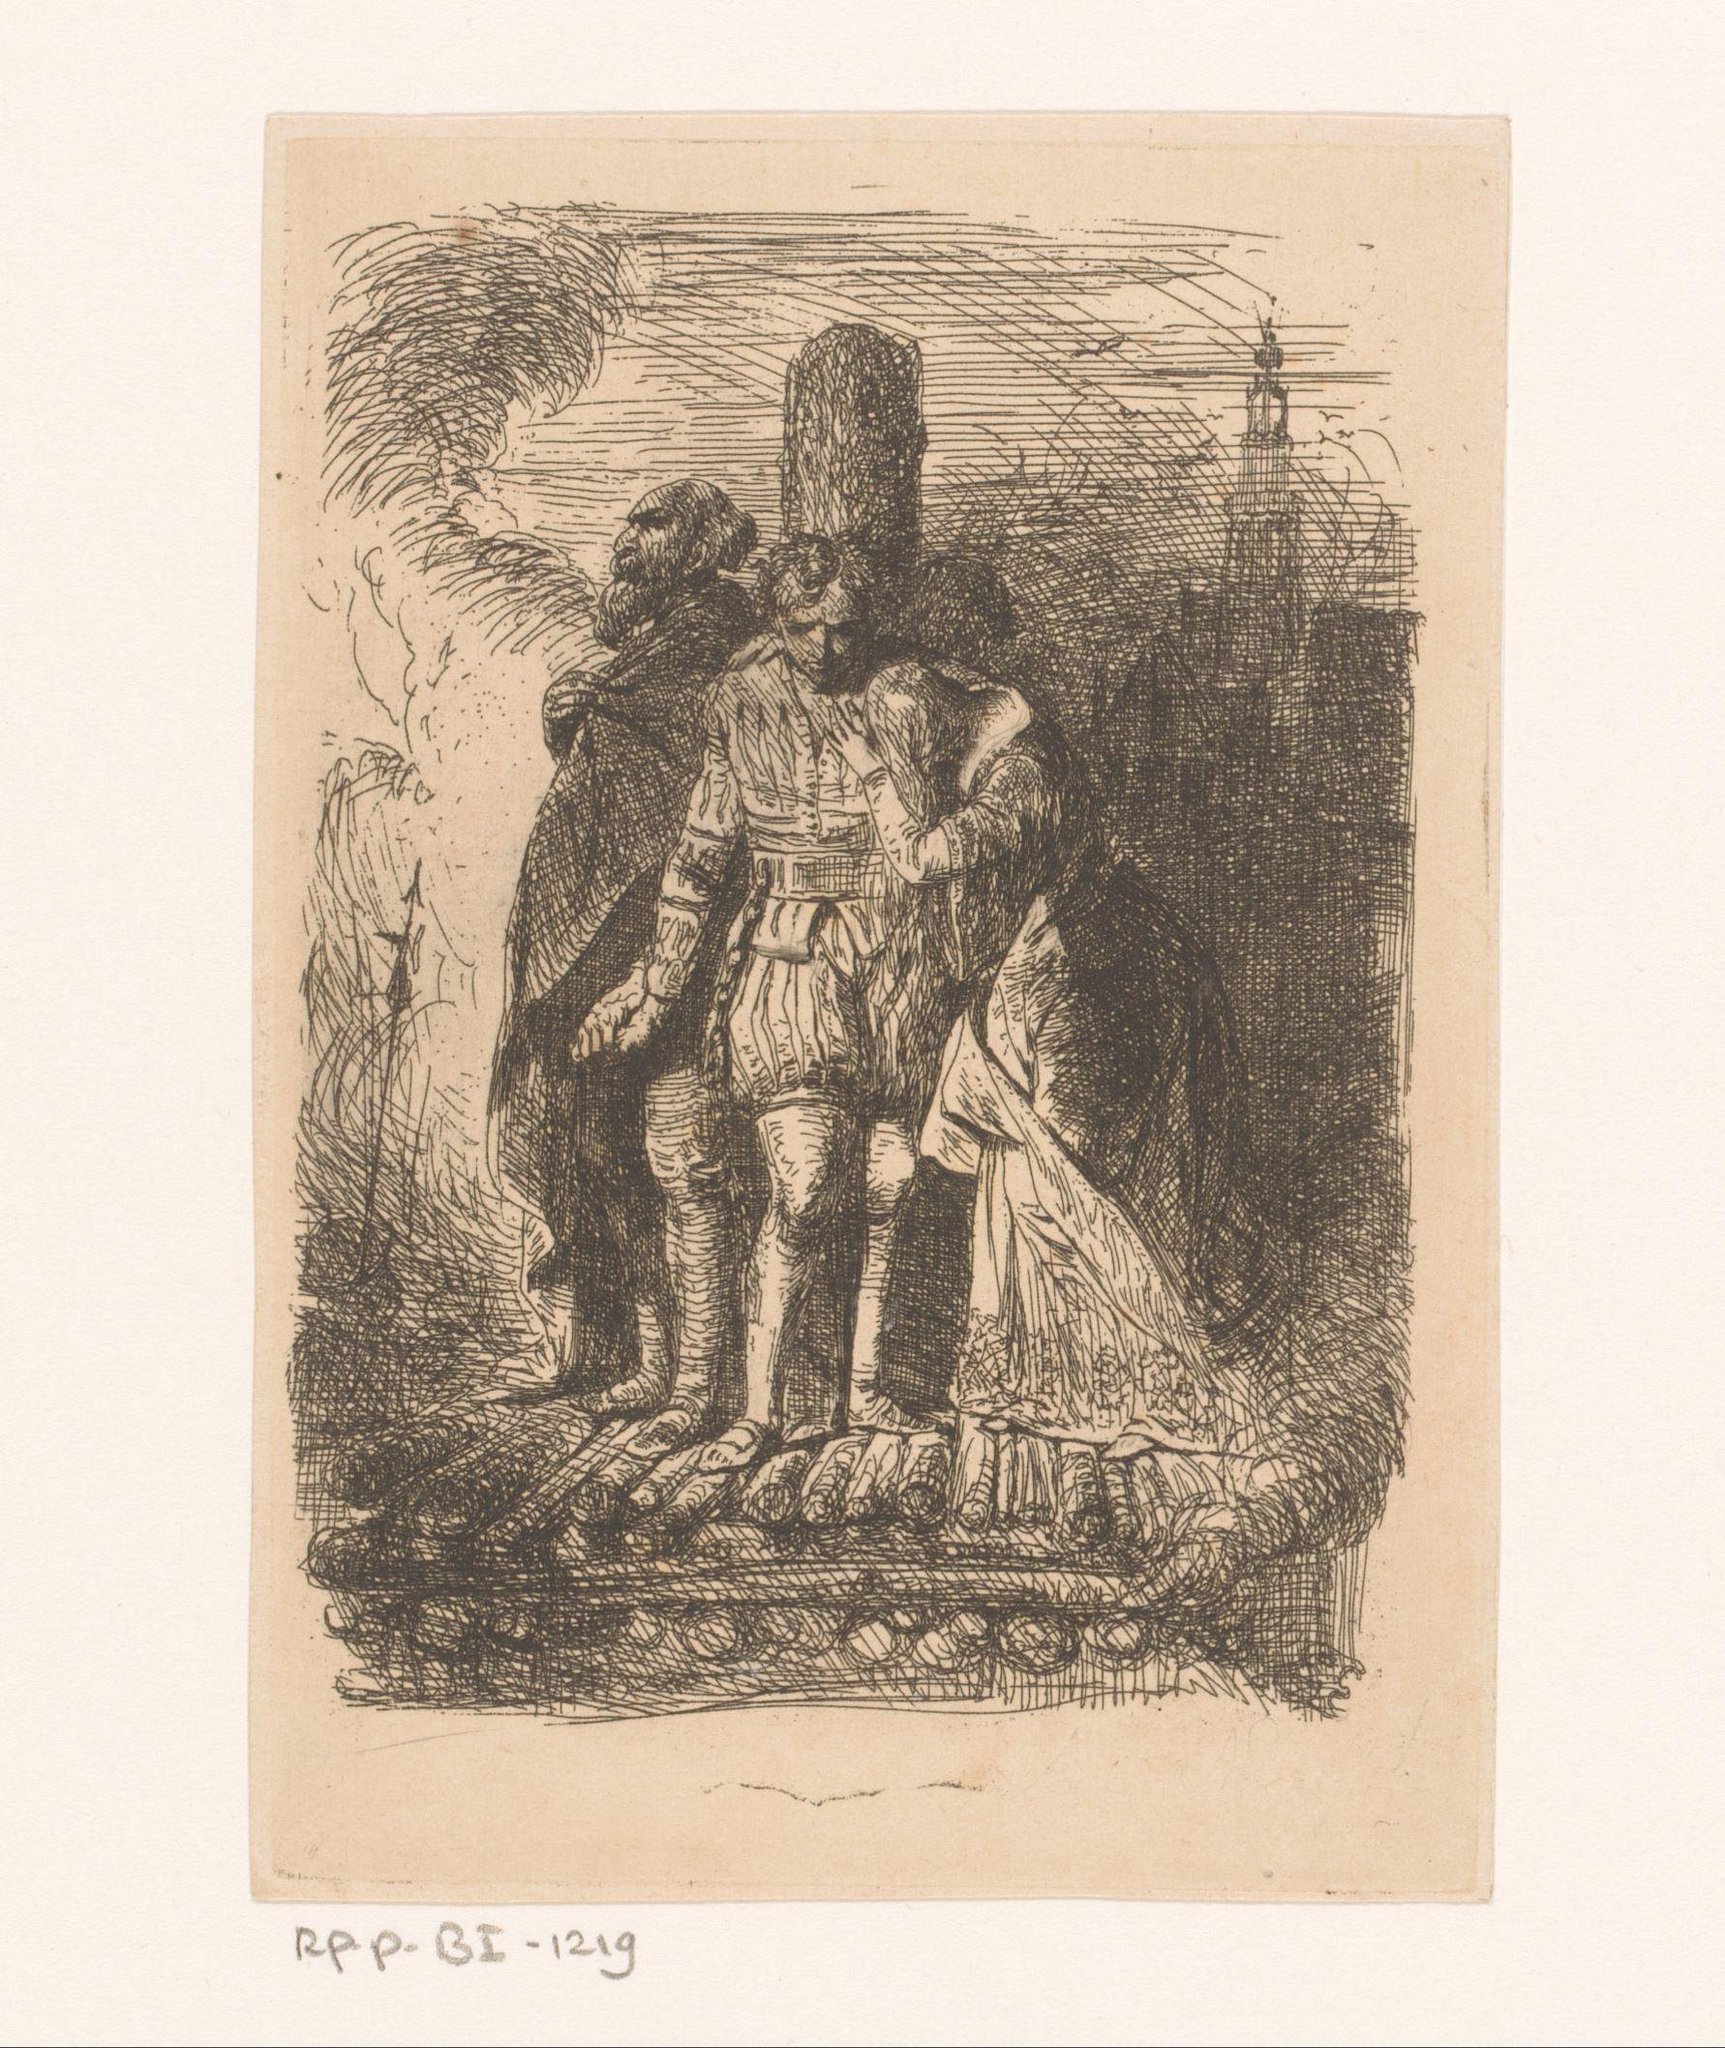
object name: print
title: Drie figuren op de brandstapel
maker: eugène françois de block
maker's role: draughtsman, painter, print maker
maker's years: 1812-1893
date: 1822-1893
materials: paper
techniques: etching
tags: violent death by burning at the stake; pyre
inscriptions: collector's mark: Lugt 2228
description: Drie figuren op de brandstapel met een kerktoren op de achtergrond.